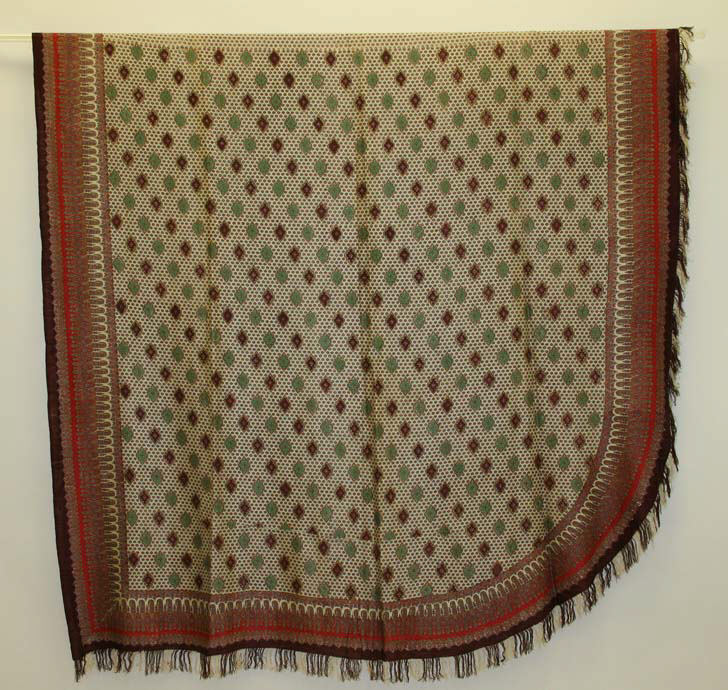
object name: shawl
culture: european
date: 1860-1869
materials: silk, wool